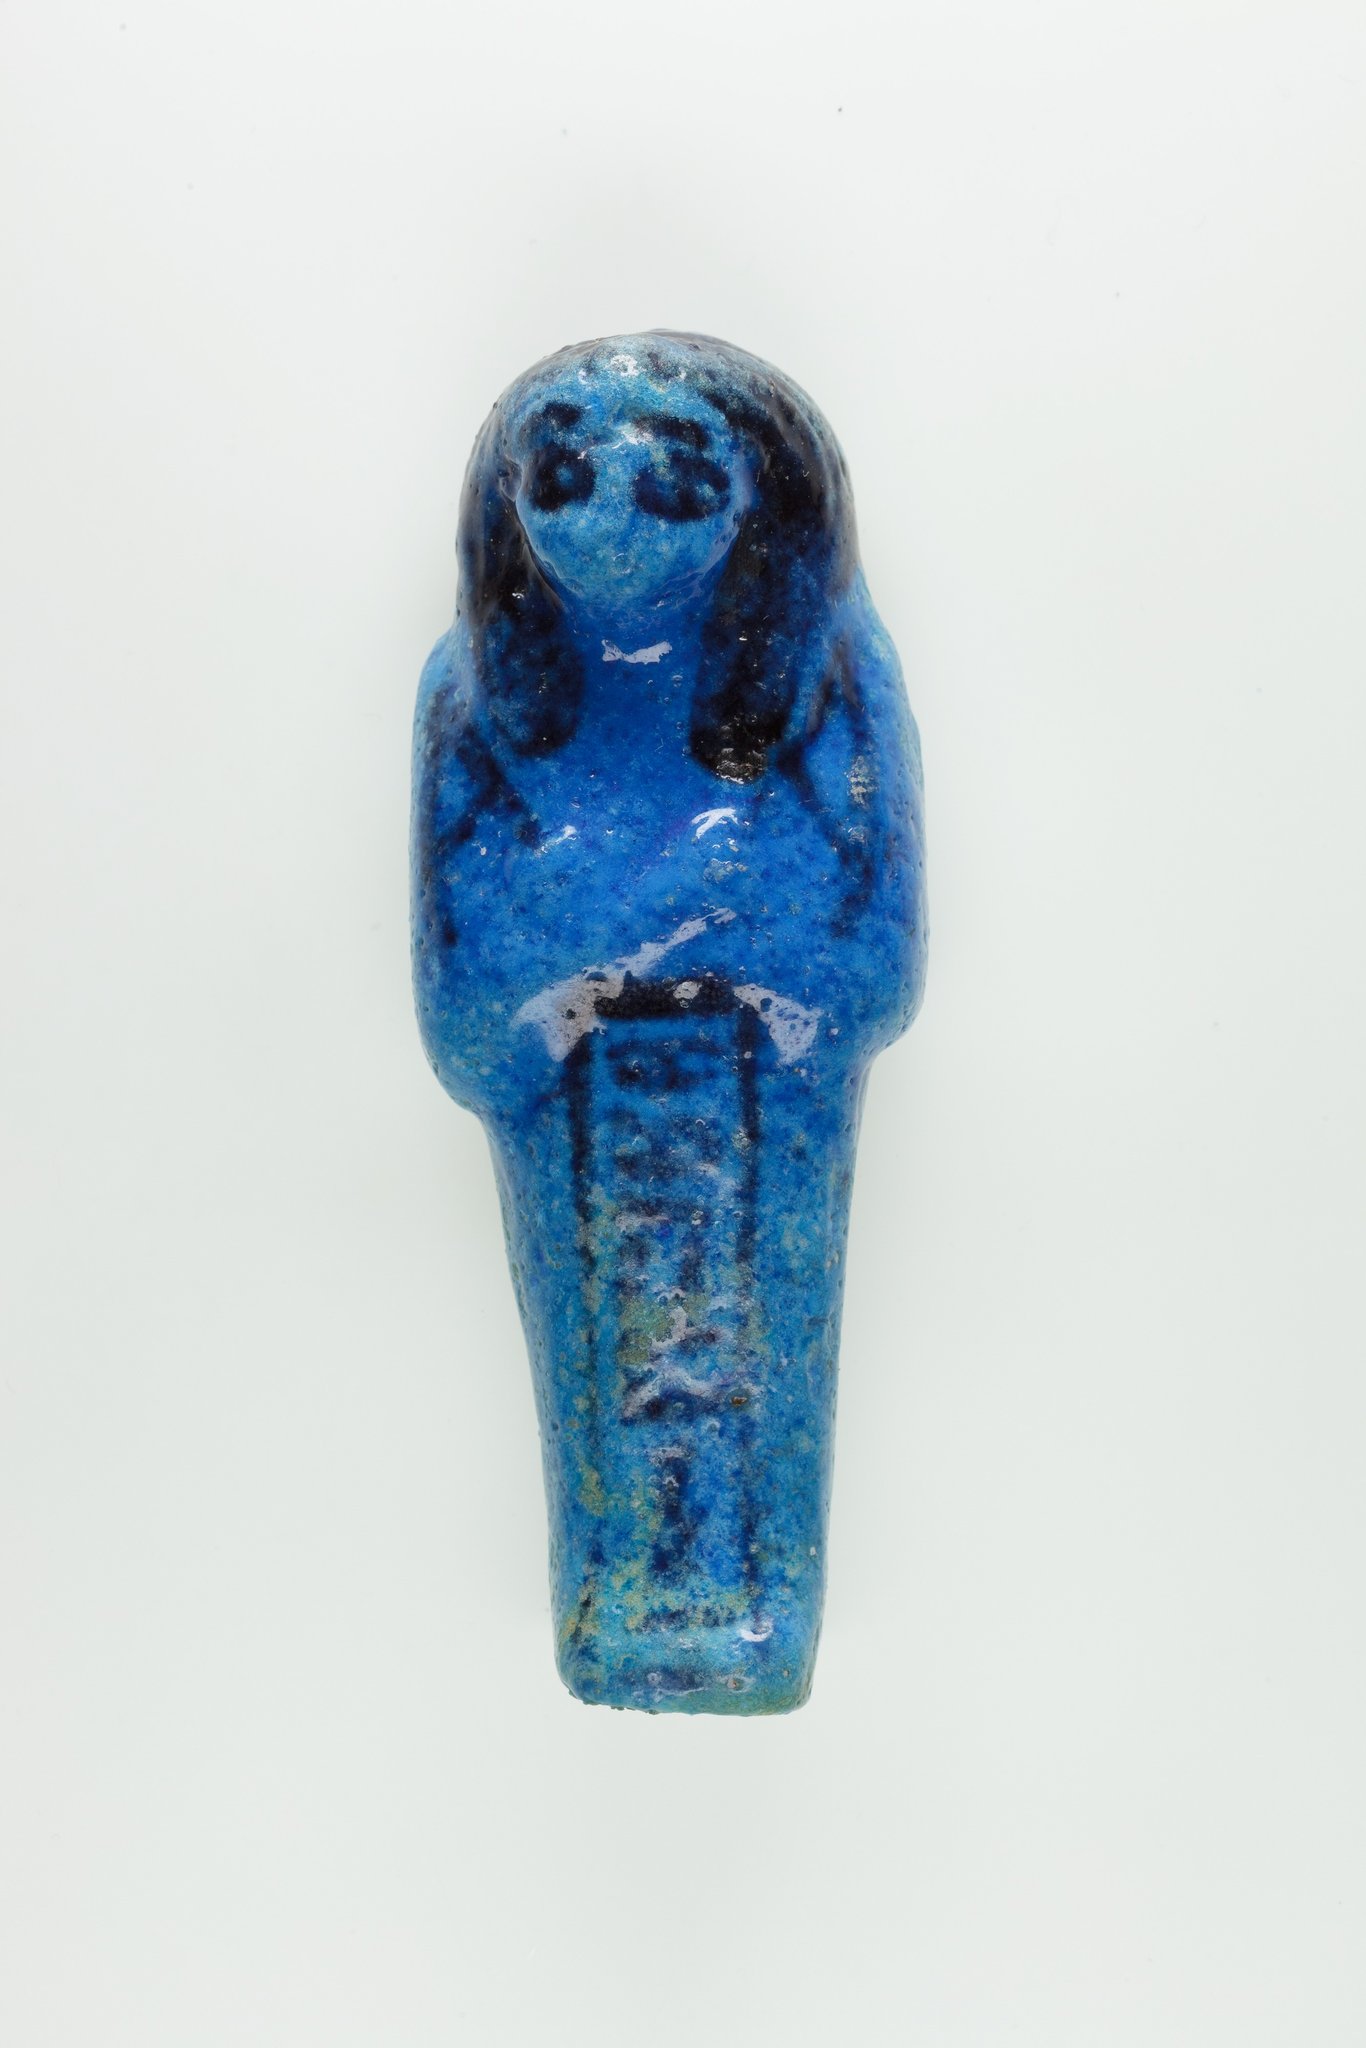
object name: shabti, worker, nauny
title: Worker Shabti of Nauny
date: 1050 BCE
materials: faience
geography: egypt